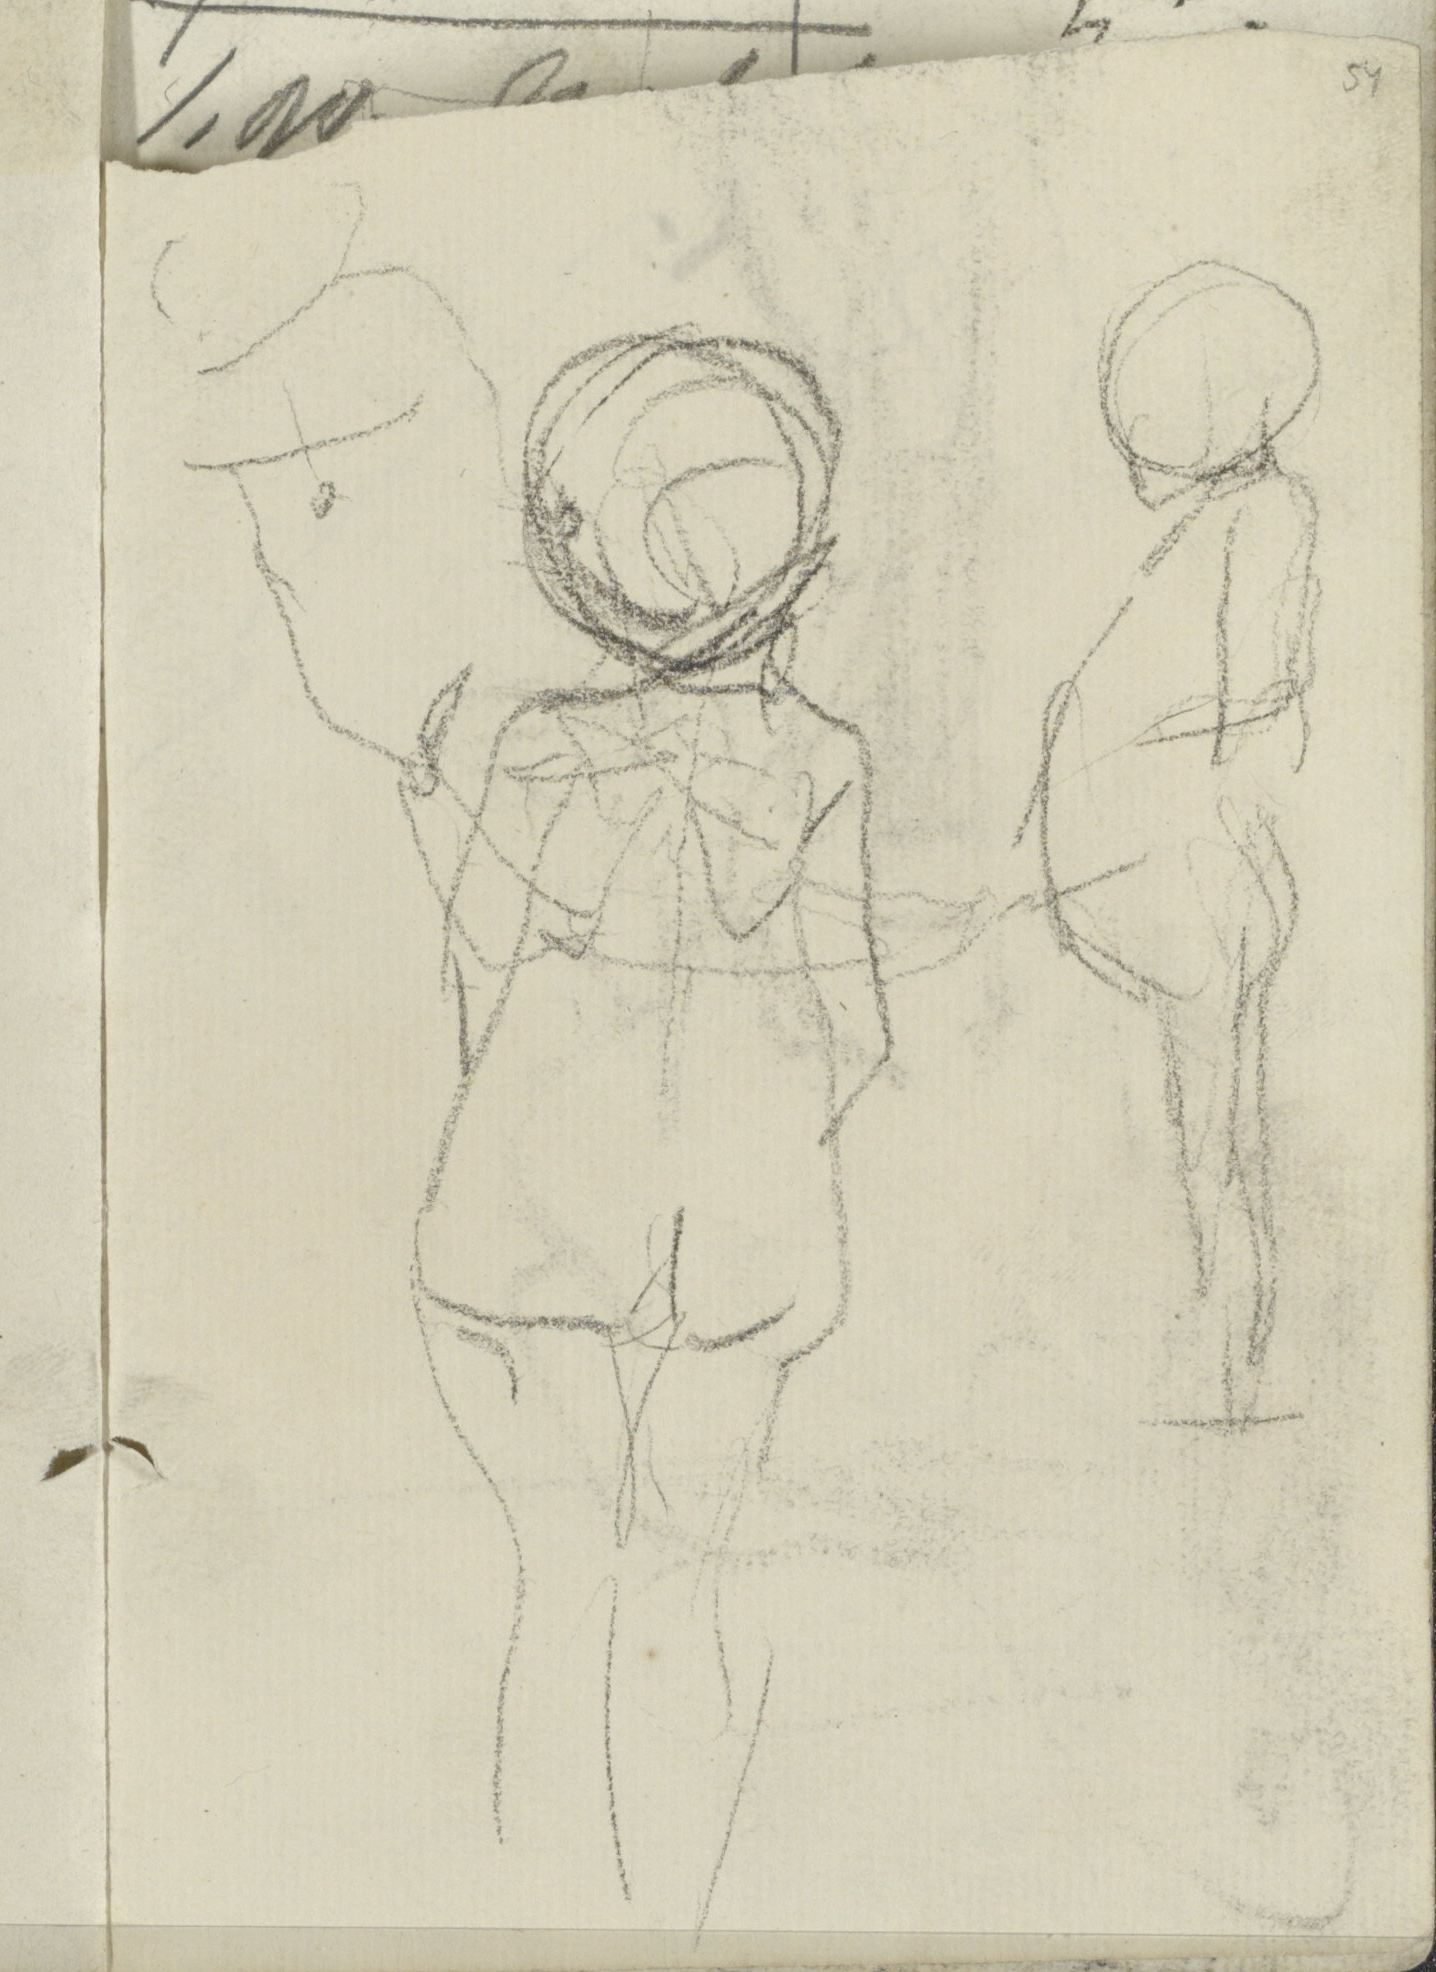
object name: sketchbook leaf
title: Twee kinderen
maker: george hendrik breitner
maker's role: draughtsman, painter, print maker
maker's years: 1857-1923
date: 1887-1889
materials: chalk, paper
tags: child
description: Pagina 54 uit een schetsboek met 27 bladen.